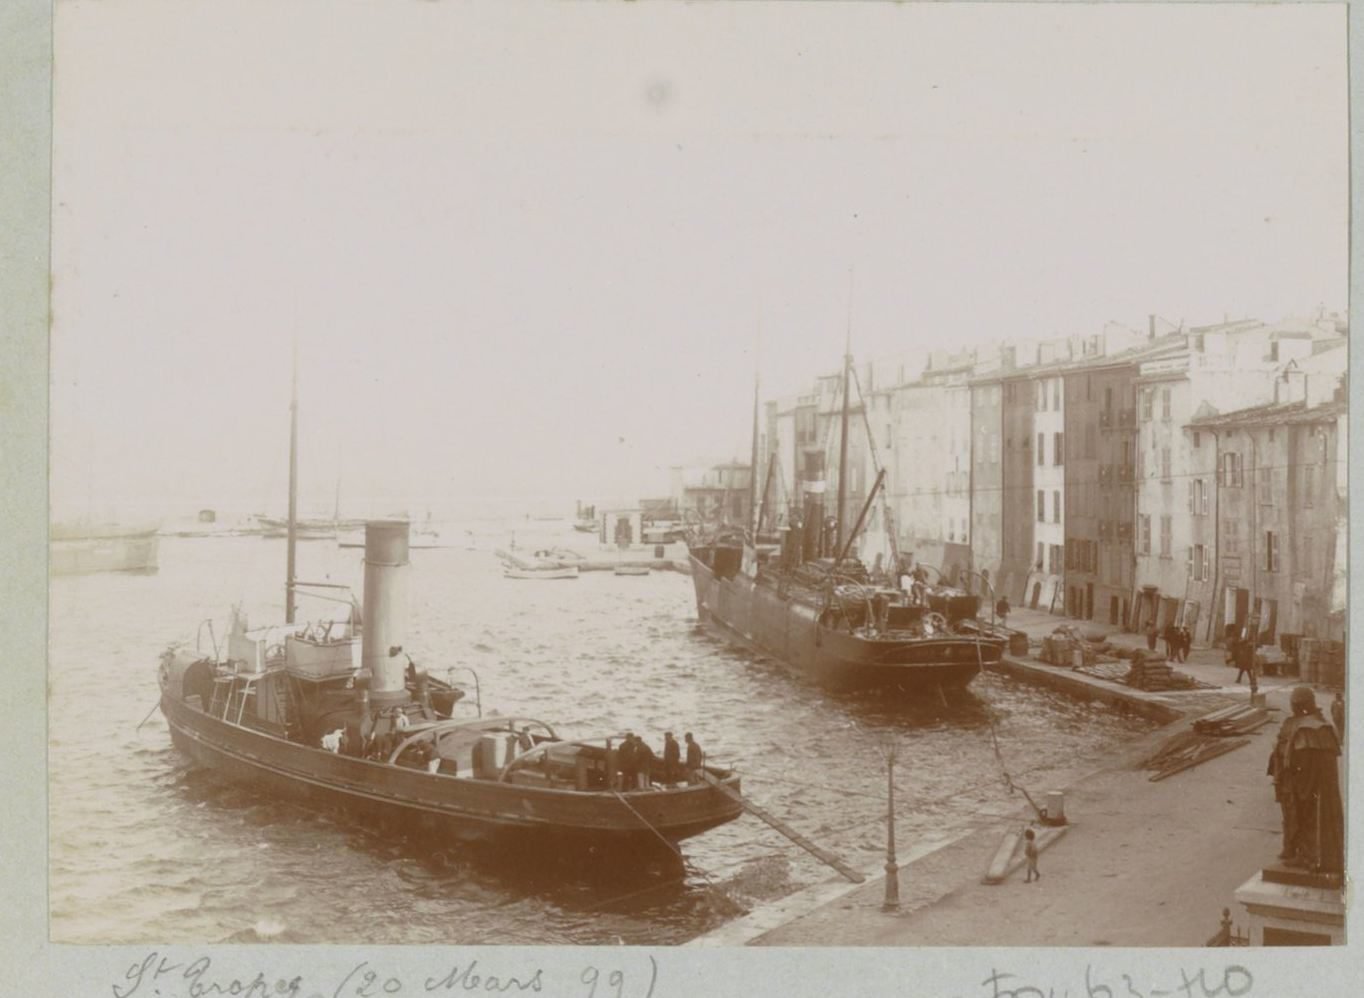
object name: photograph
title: Gezicht op schepen in de haven van Saint-Tropez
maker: delizy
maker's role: manufacturer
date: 1899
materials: paper, photographic support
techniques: gelatin silver print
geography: saint-tropez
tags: sailing-ship, sailing-boat, harbour (+ view ~ vehicle, ship, etc.), steamship, motorship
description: Onderdeel van Fotoalbum van een Franse amateurfotograaf met opnames van uitstapjes in Frankrijk, Spanje, België, Luxemburg en Nederland, de eerste automobielen en autoraces.